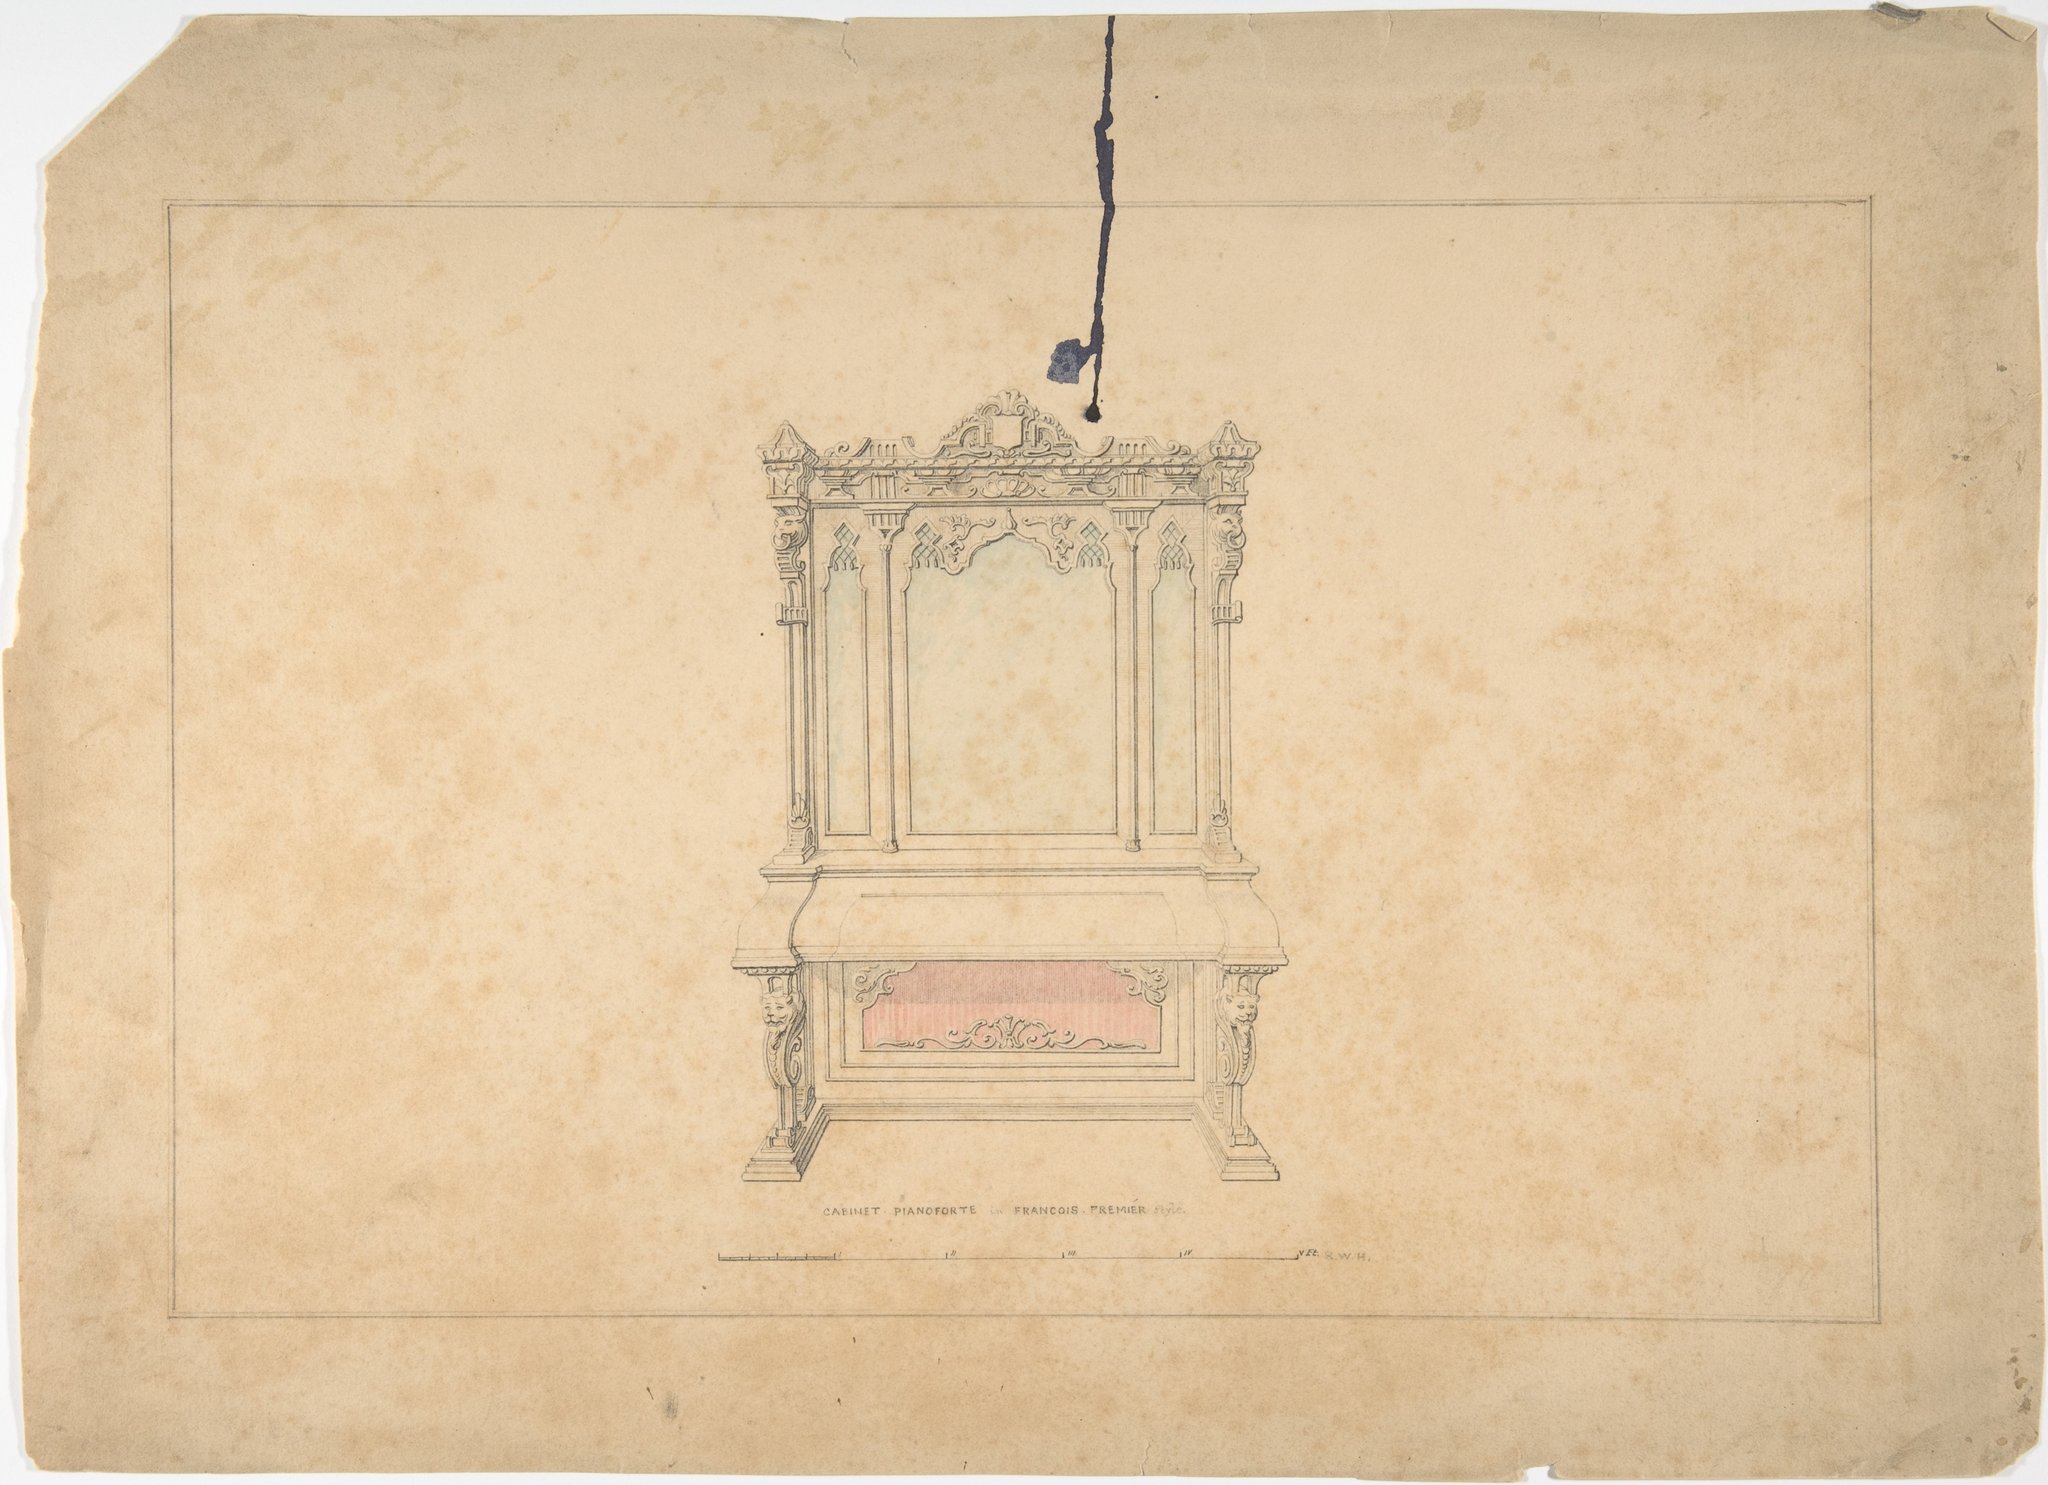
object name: drawing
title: Design for Cabinet Pianoforte, François Premier Style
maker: robert william hume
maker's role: artist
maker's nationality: british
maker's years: 1816-1904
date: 1835-1900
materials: graphite, ink, watercolor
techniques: pen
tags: pianos,cabinets